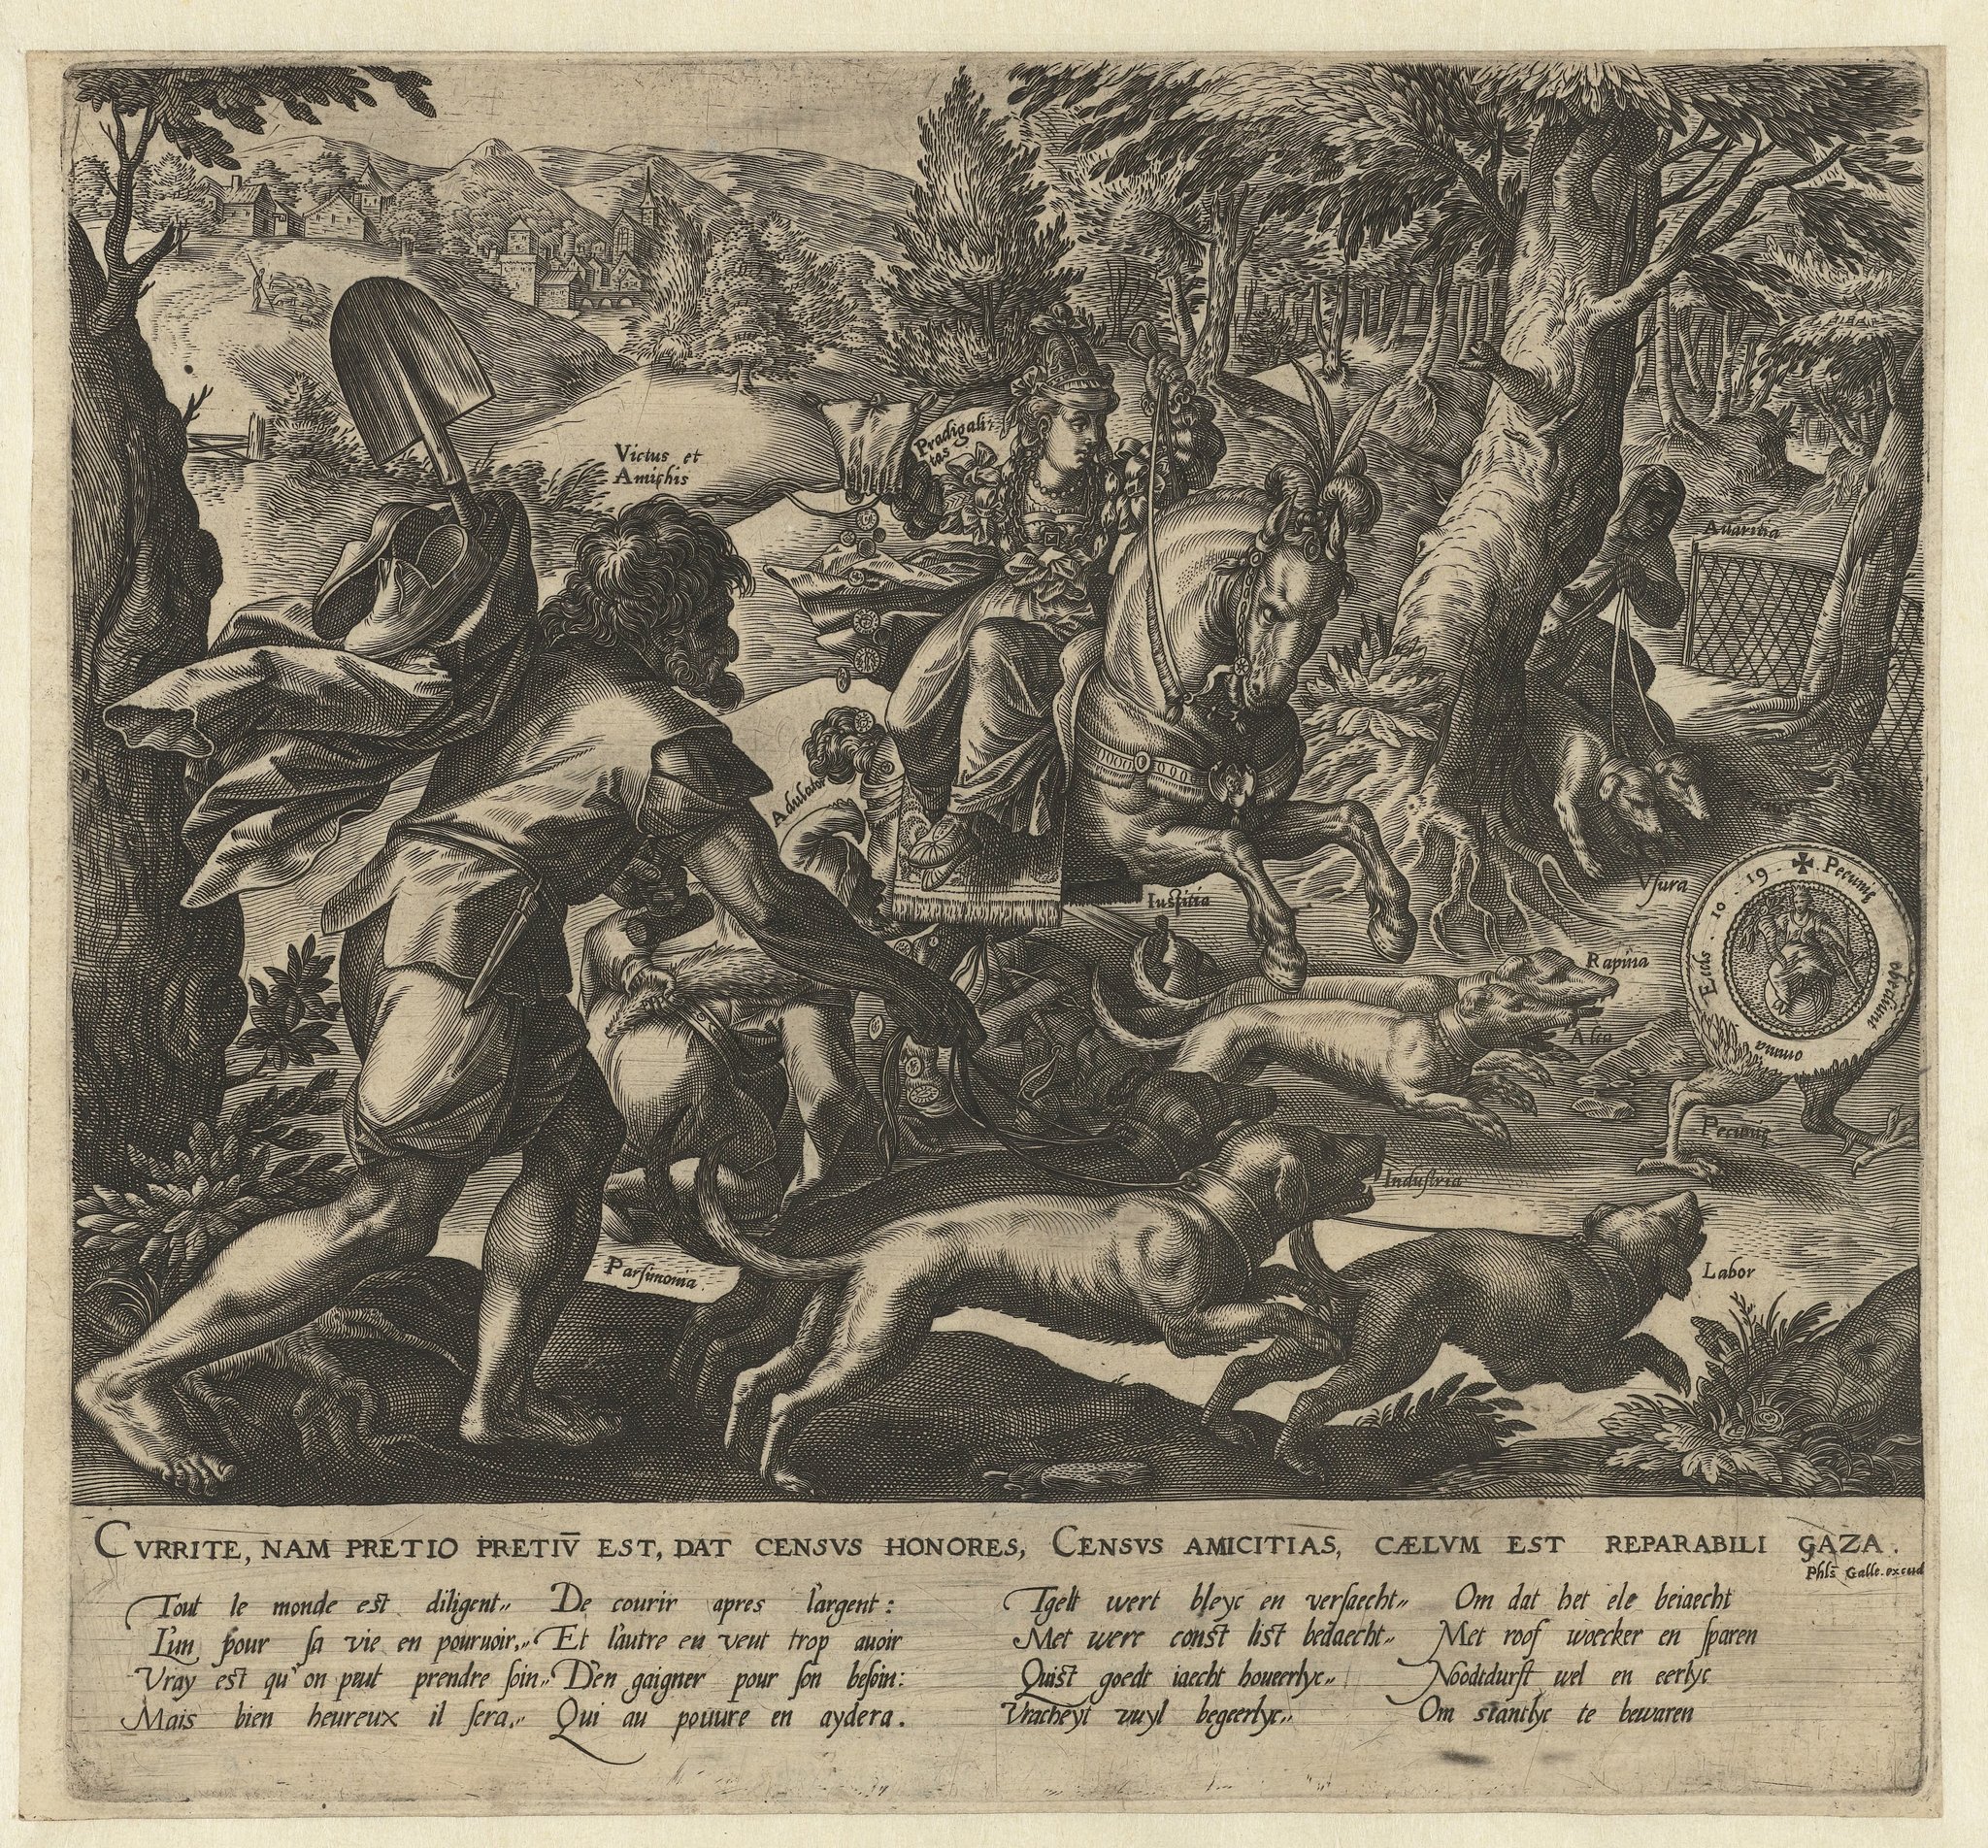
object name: print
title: De jacht naar het geld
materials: paper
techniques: engraving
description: in de marge Currite, nam pretio enz., acht fransche en acht hollandsche versregels, v.o. rechts: Henr. Goltzius fecit